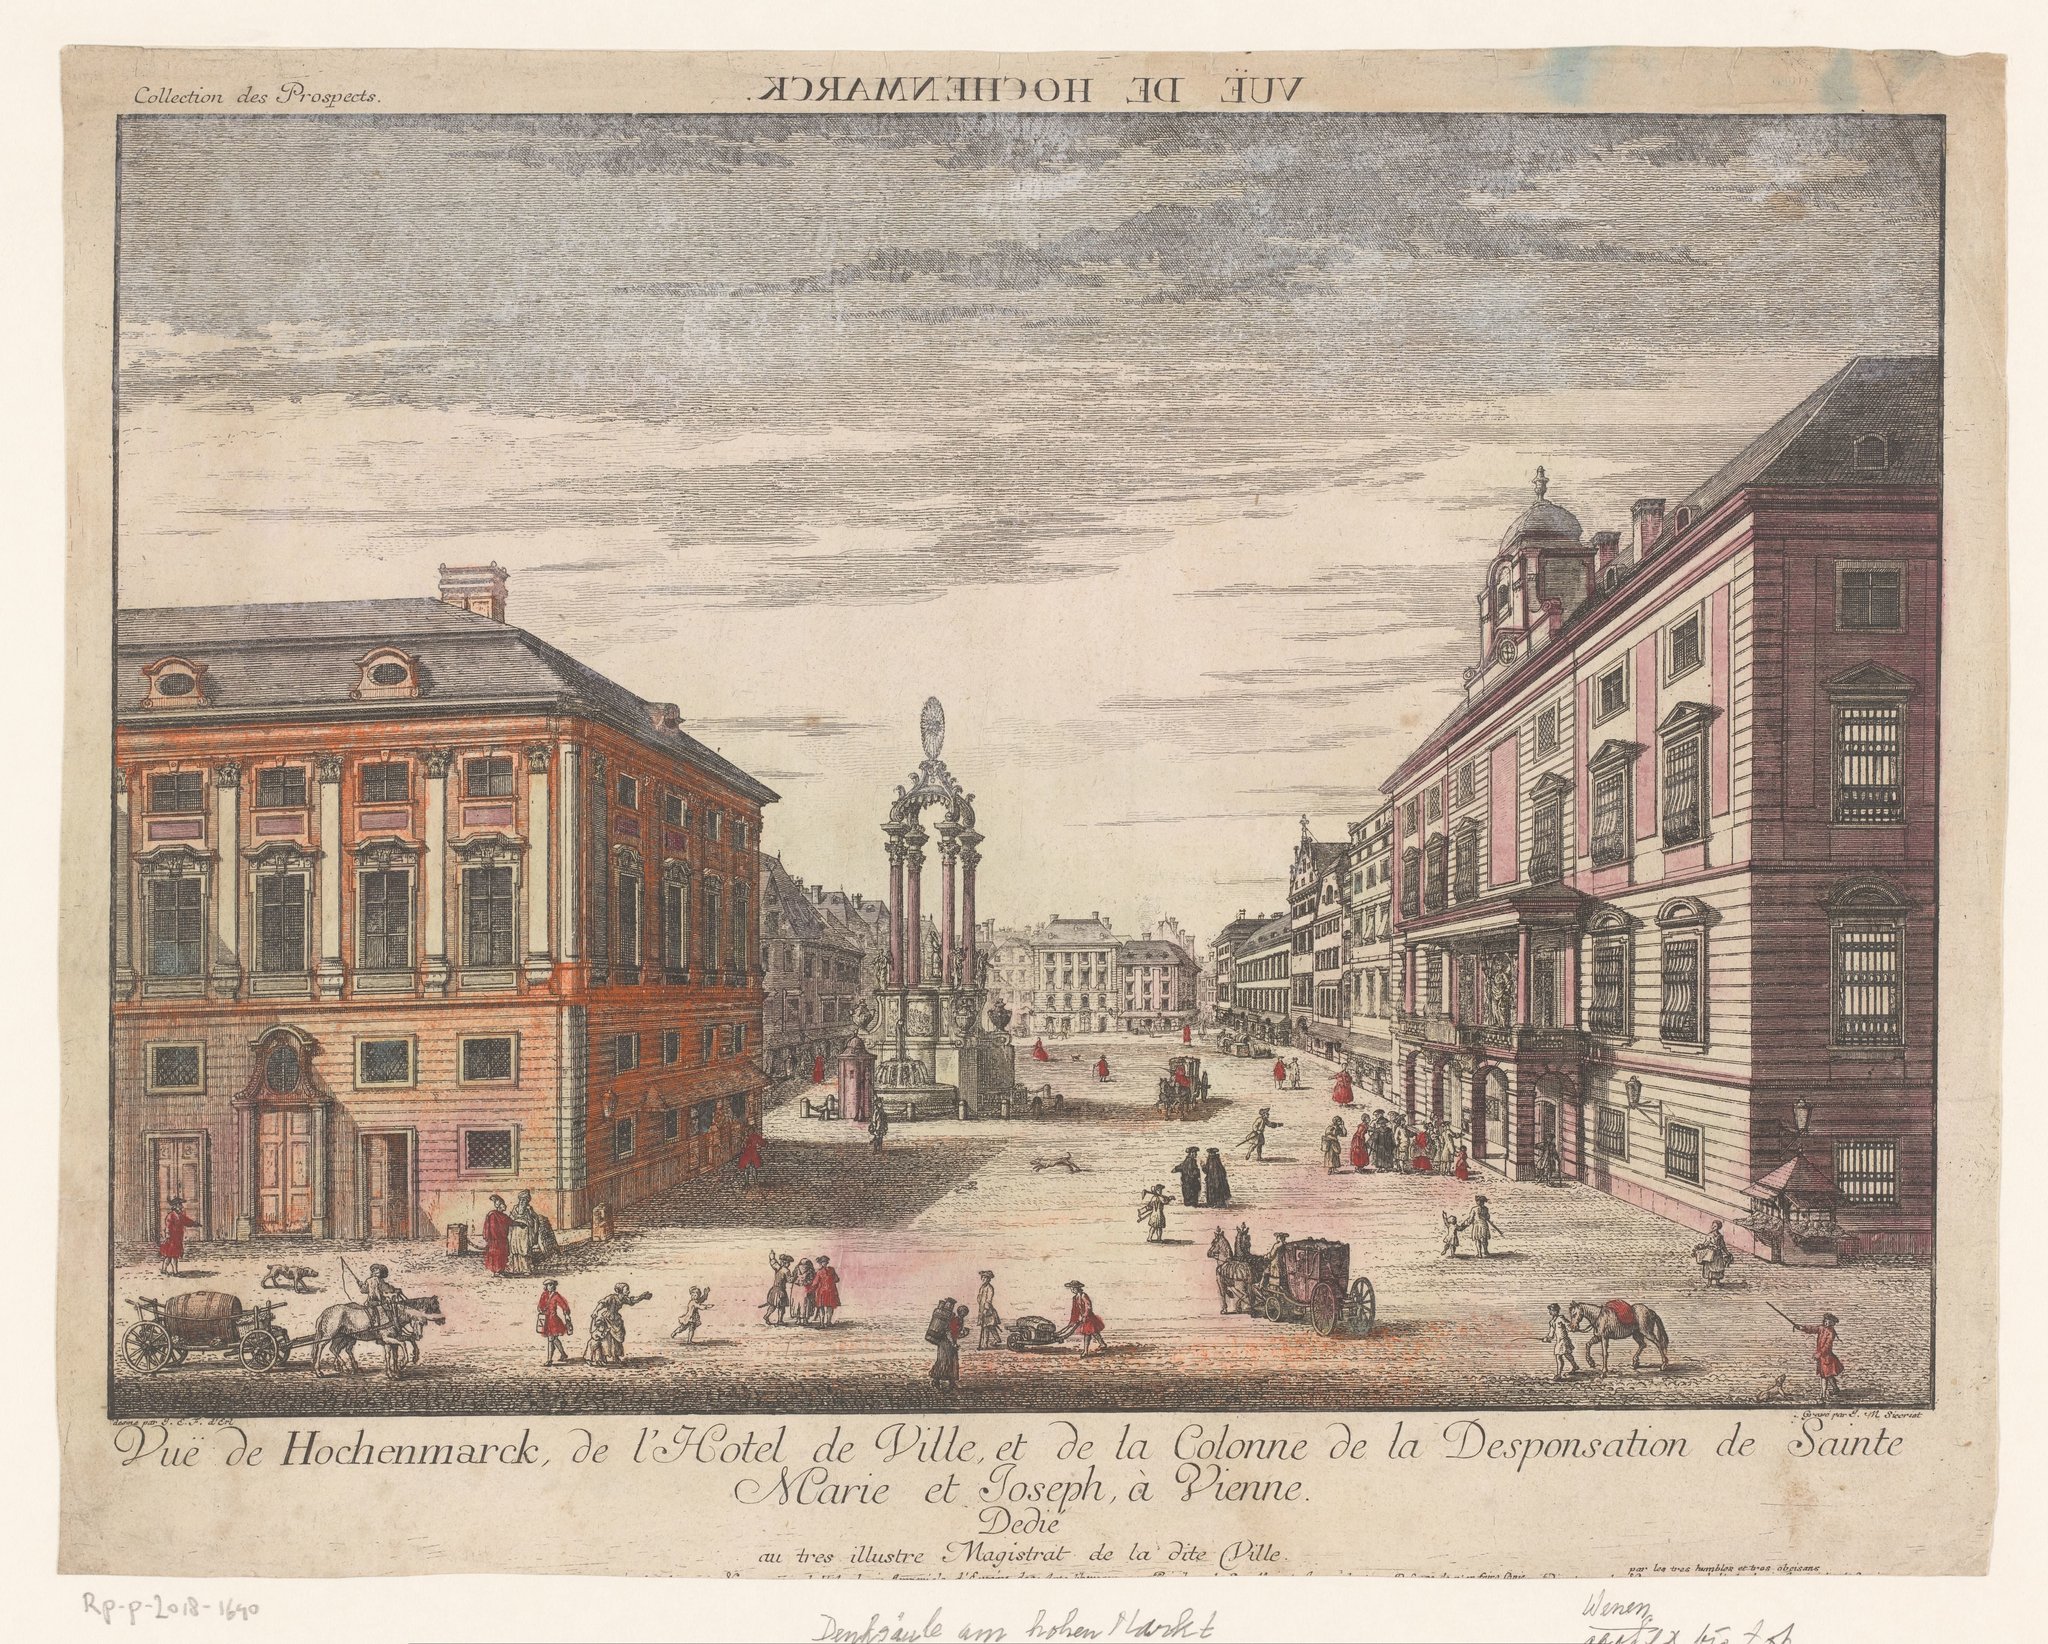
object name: print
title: Vuë de Hochenmarck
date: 1755-1779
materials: paper, watercolor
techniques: etching, hand coloring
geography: augsburg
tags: spring (fluids extracted from the earth), square, place, circus, etc. (+ city(-scape) with figures, staffage)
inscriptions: collector's mark: Lugt 2228